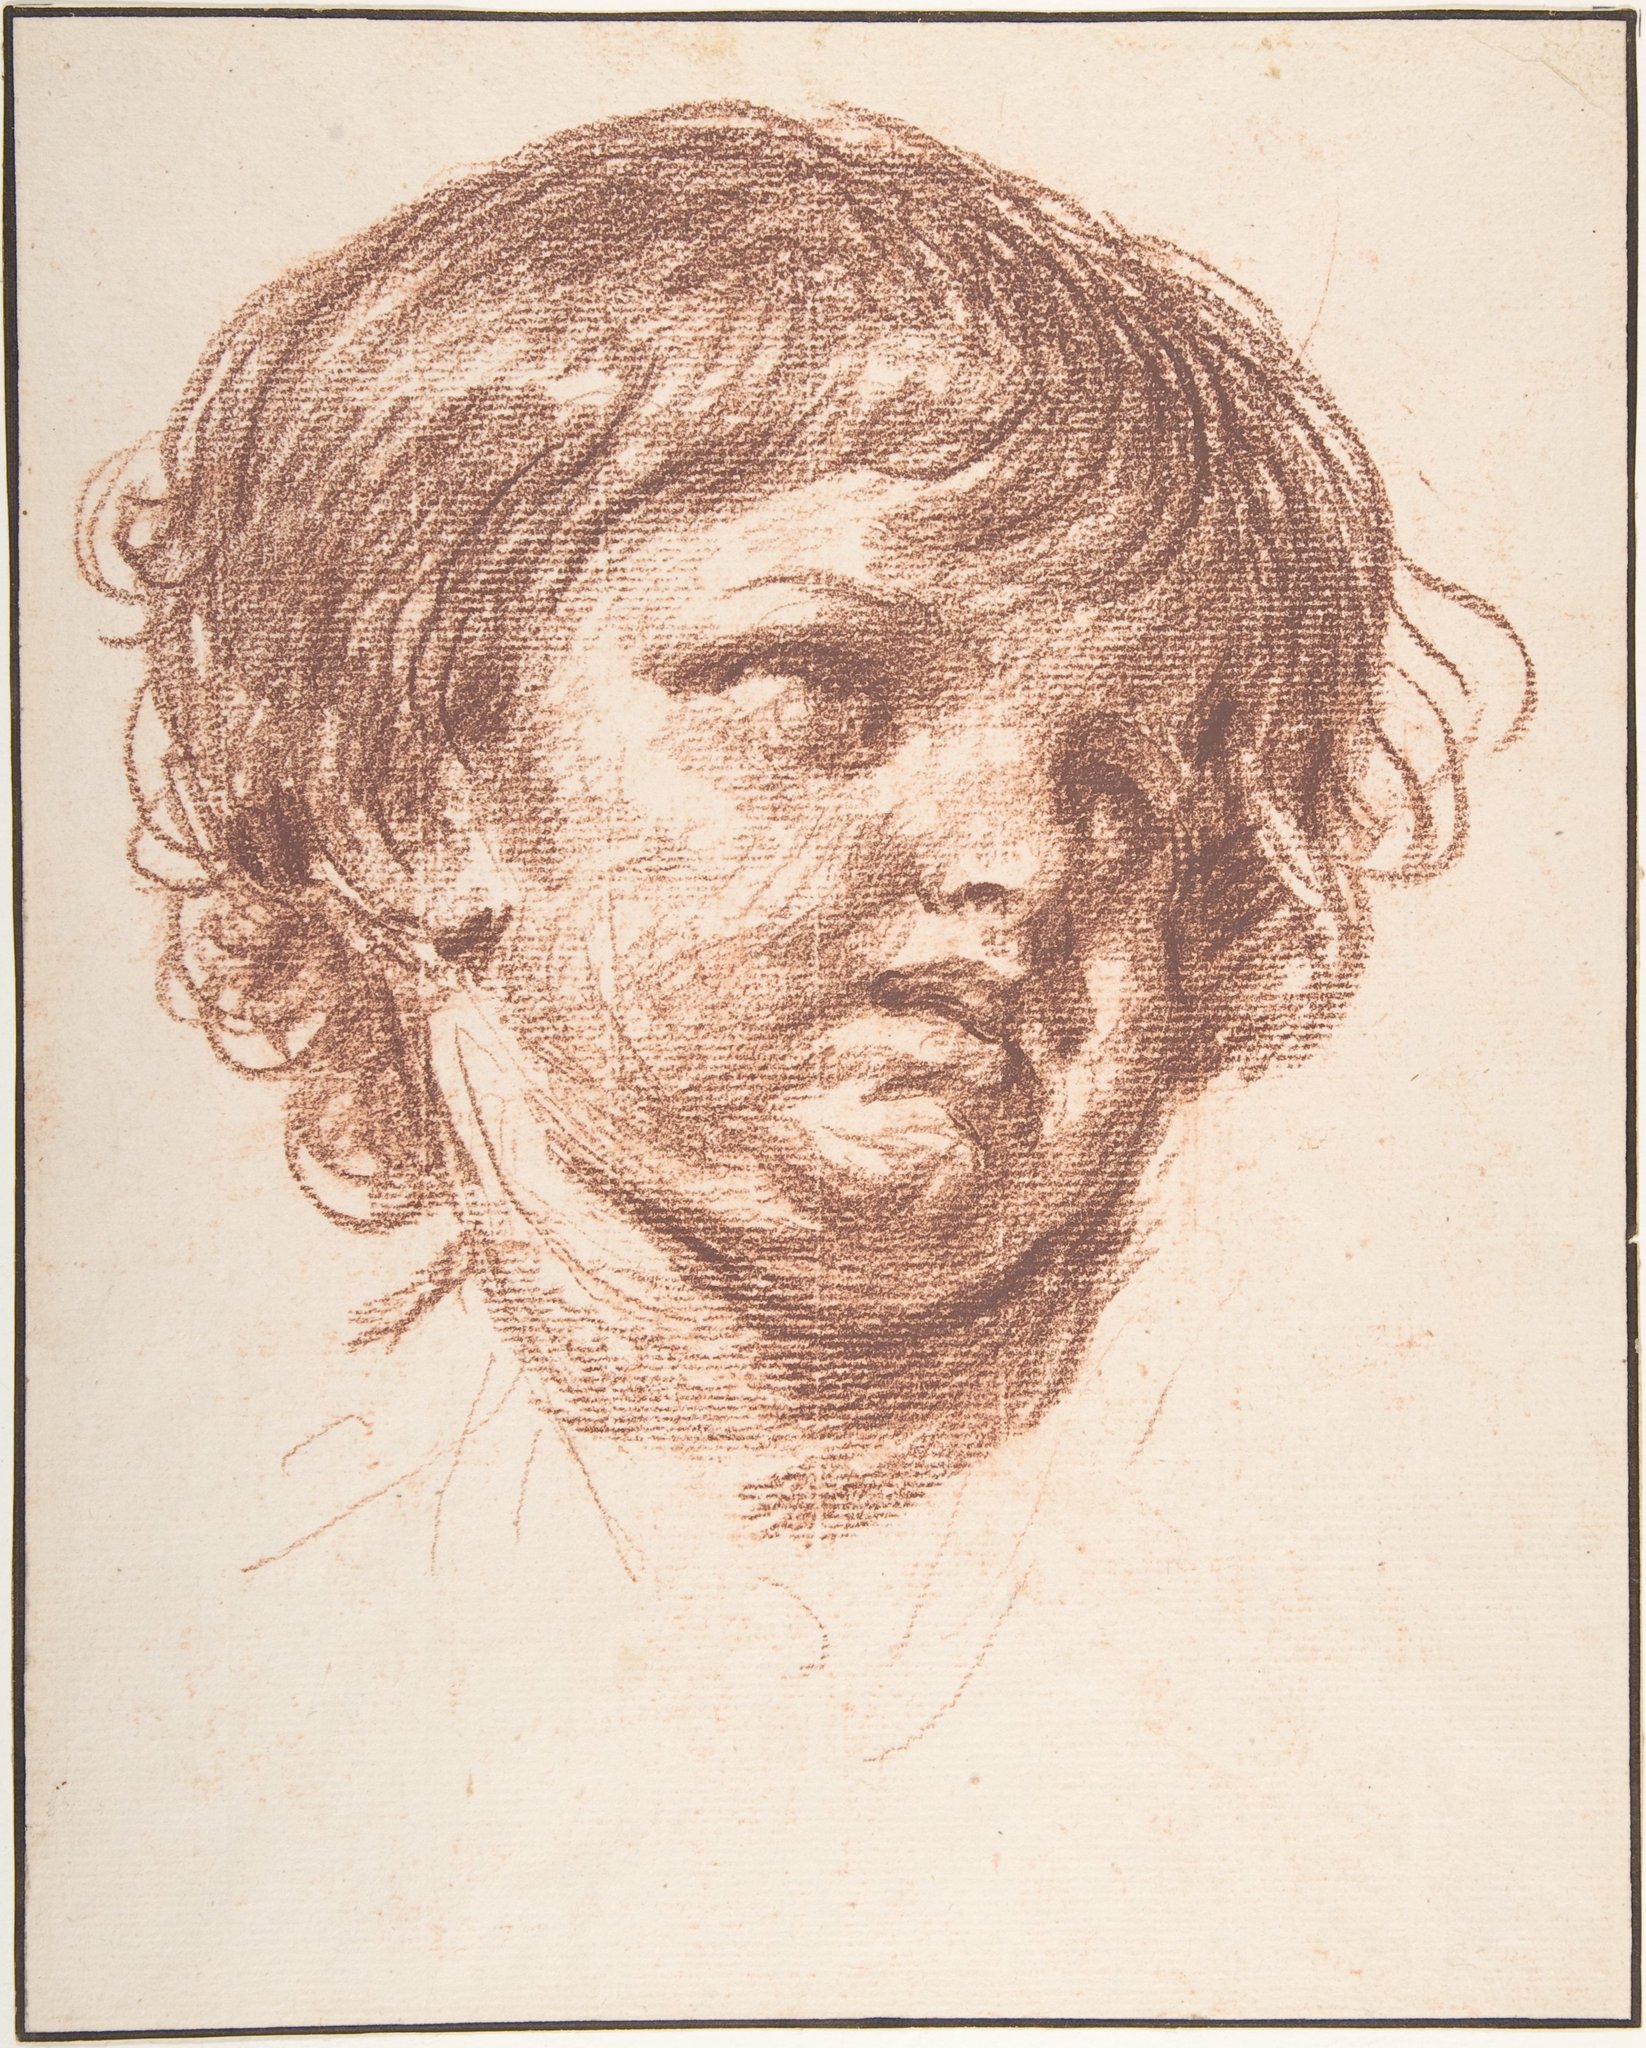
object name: drawing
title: Head of a Young Boy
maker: jean-baptiste greuze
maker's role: artist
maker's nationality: french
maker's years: 1725-1805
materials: chalk, ink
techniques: pen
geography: france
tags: heads,boys